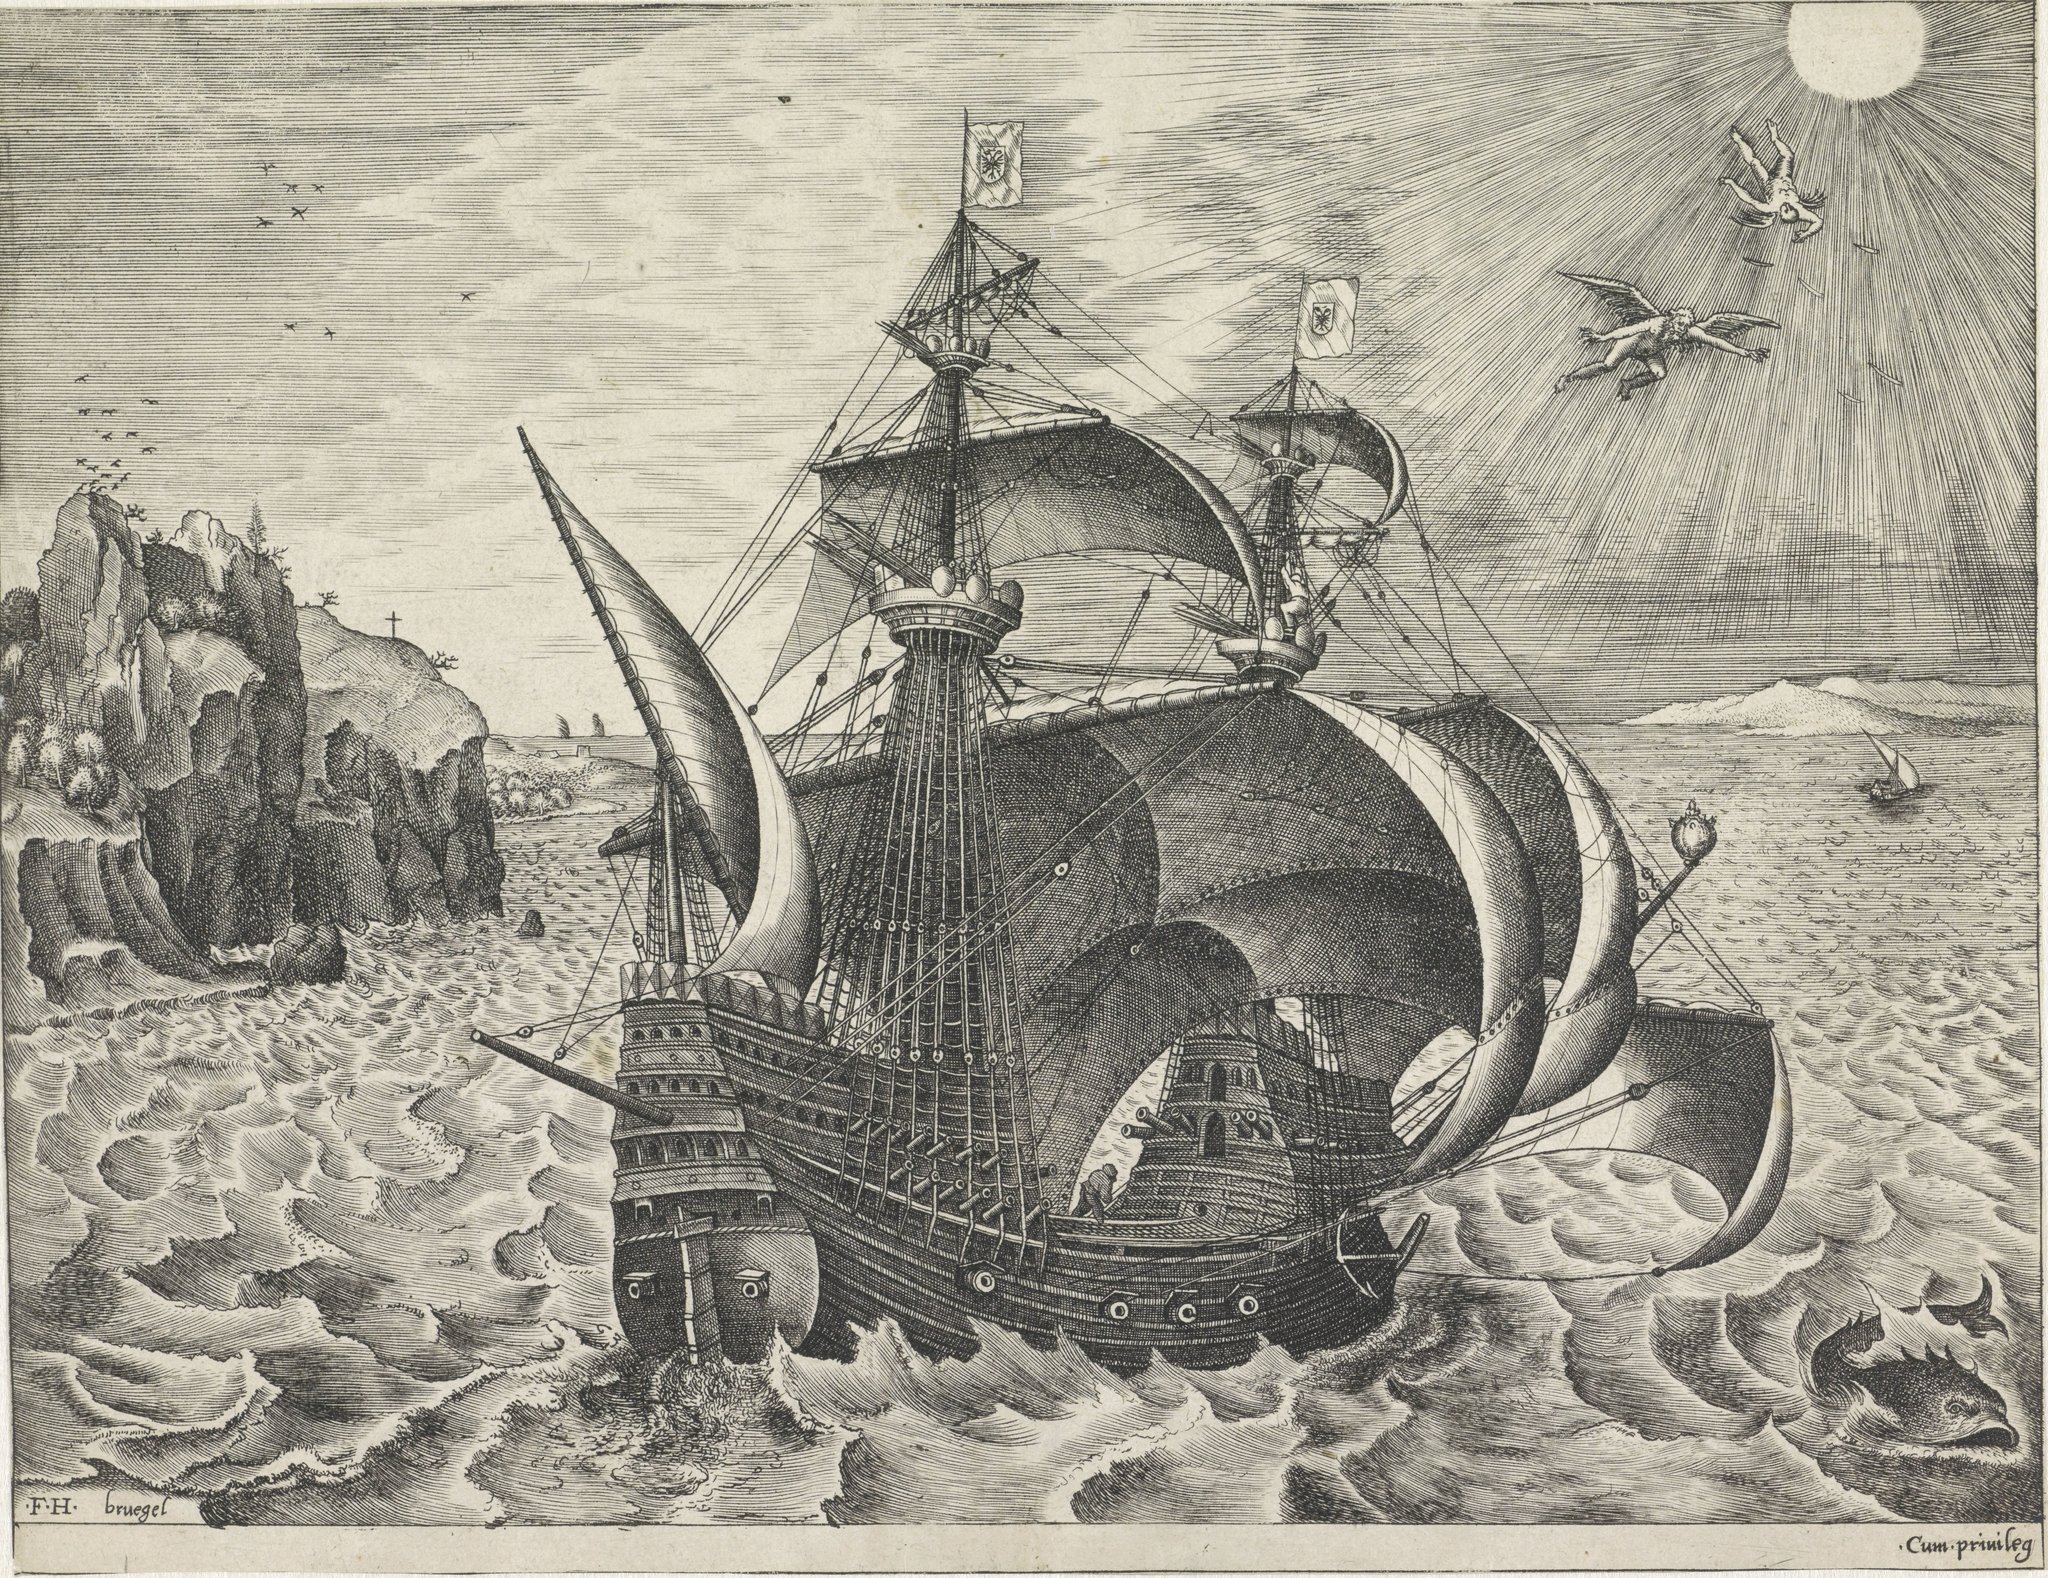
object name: print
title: Zeilschip met de val van Icarus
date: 1561-1565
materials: paper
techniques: engraving, etching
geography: antwerp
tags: death i.e. the fall of icarus (daedalus present), ships (in general)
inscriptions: collector's mark: Lugt 2228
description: Een zeilschip in het water voor een kust. In de lucht de val van Icarus.